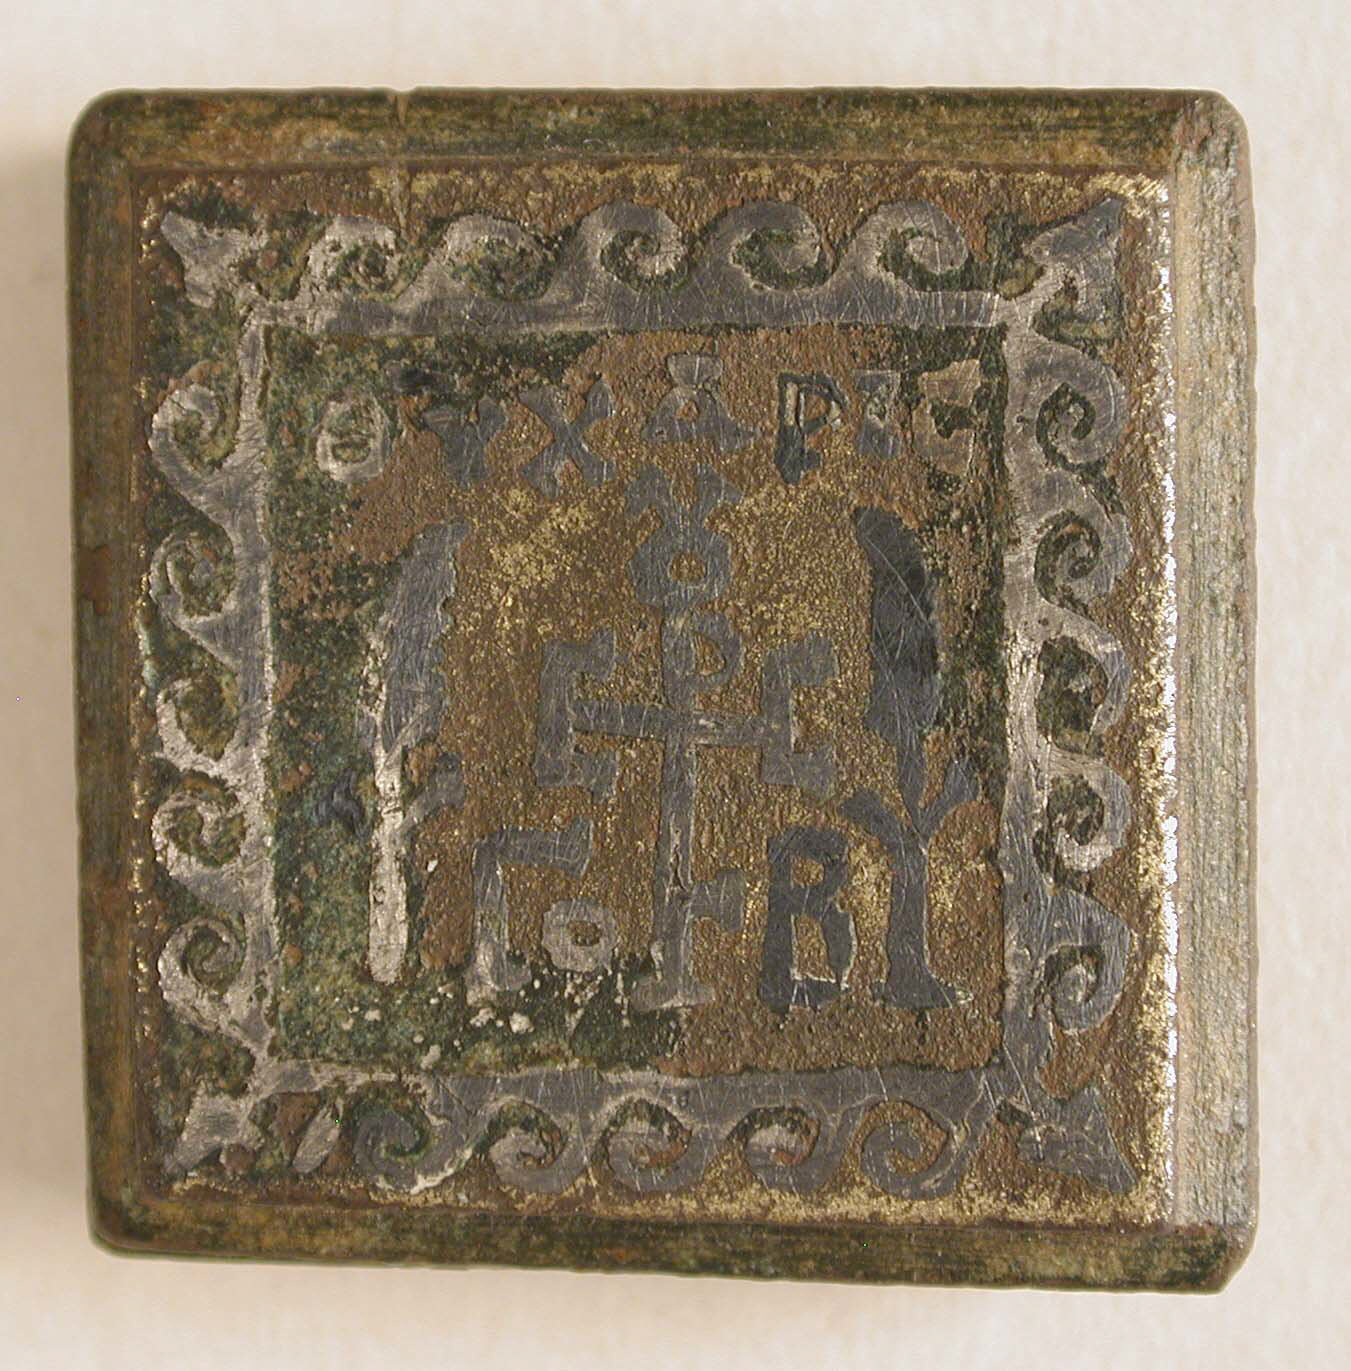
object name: weight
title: Balance Weight with Monogram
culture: byzantine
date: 501-600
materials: copper alloy, silver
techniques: inlay